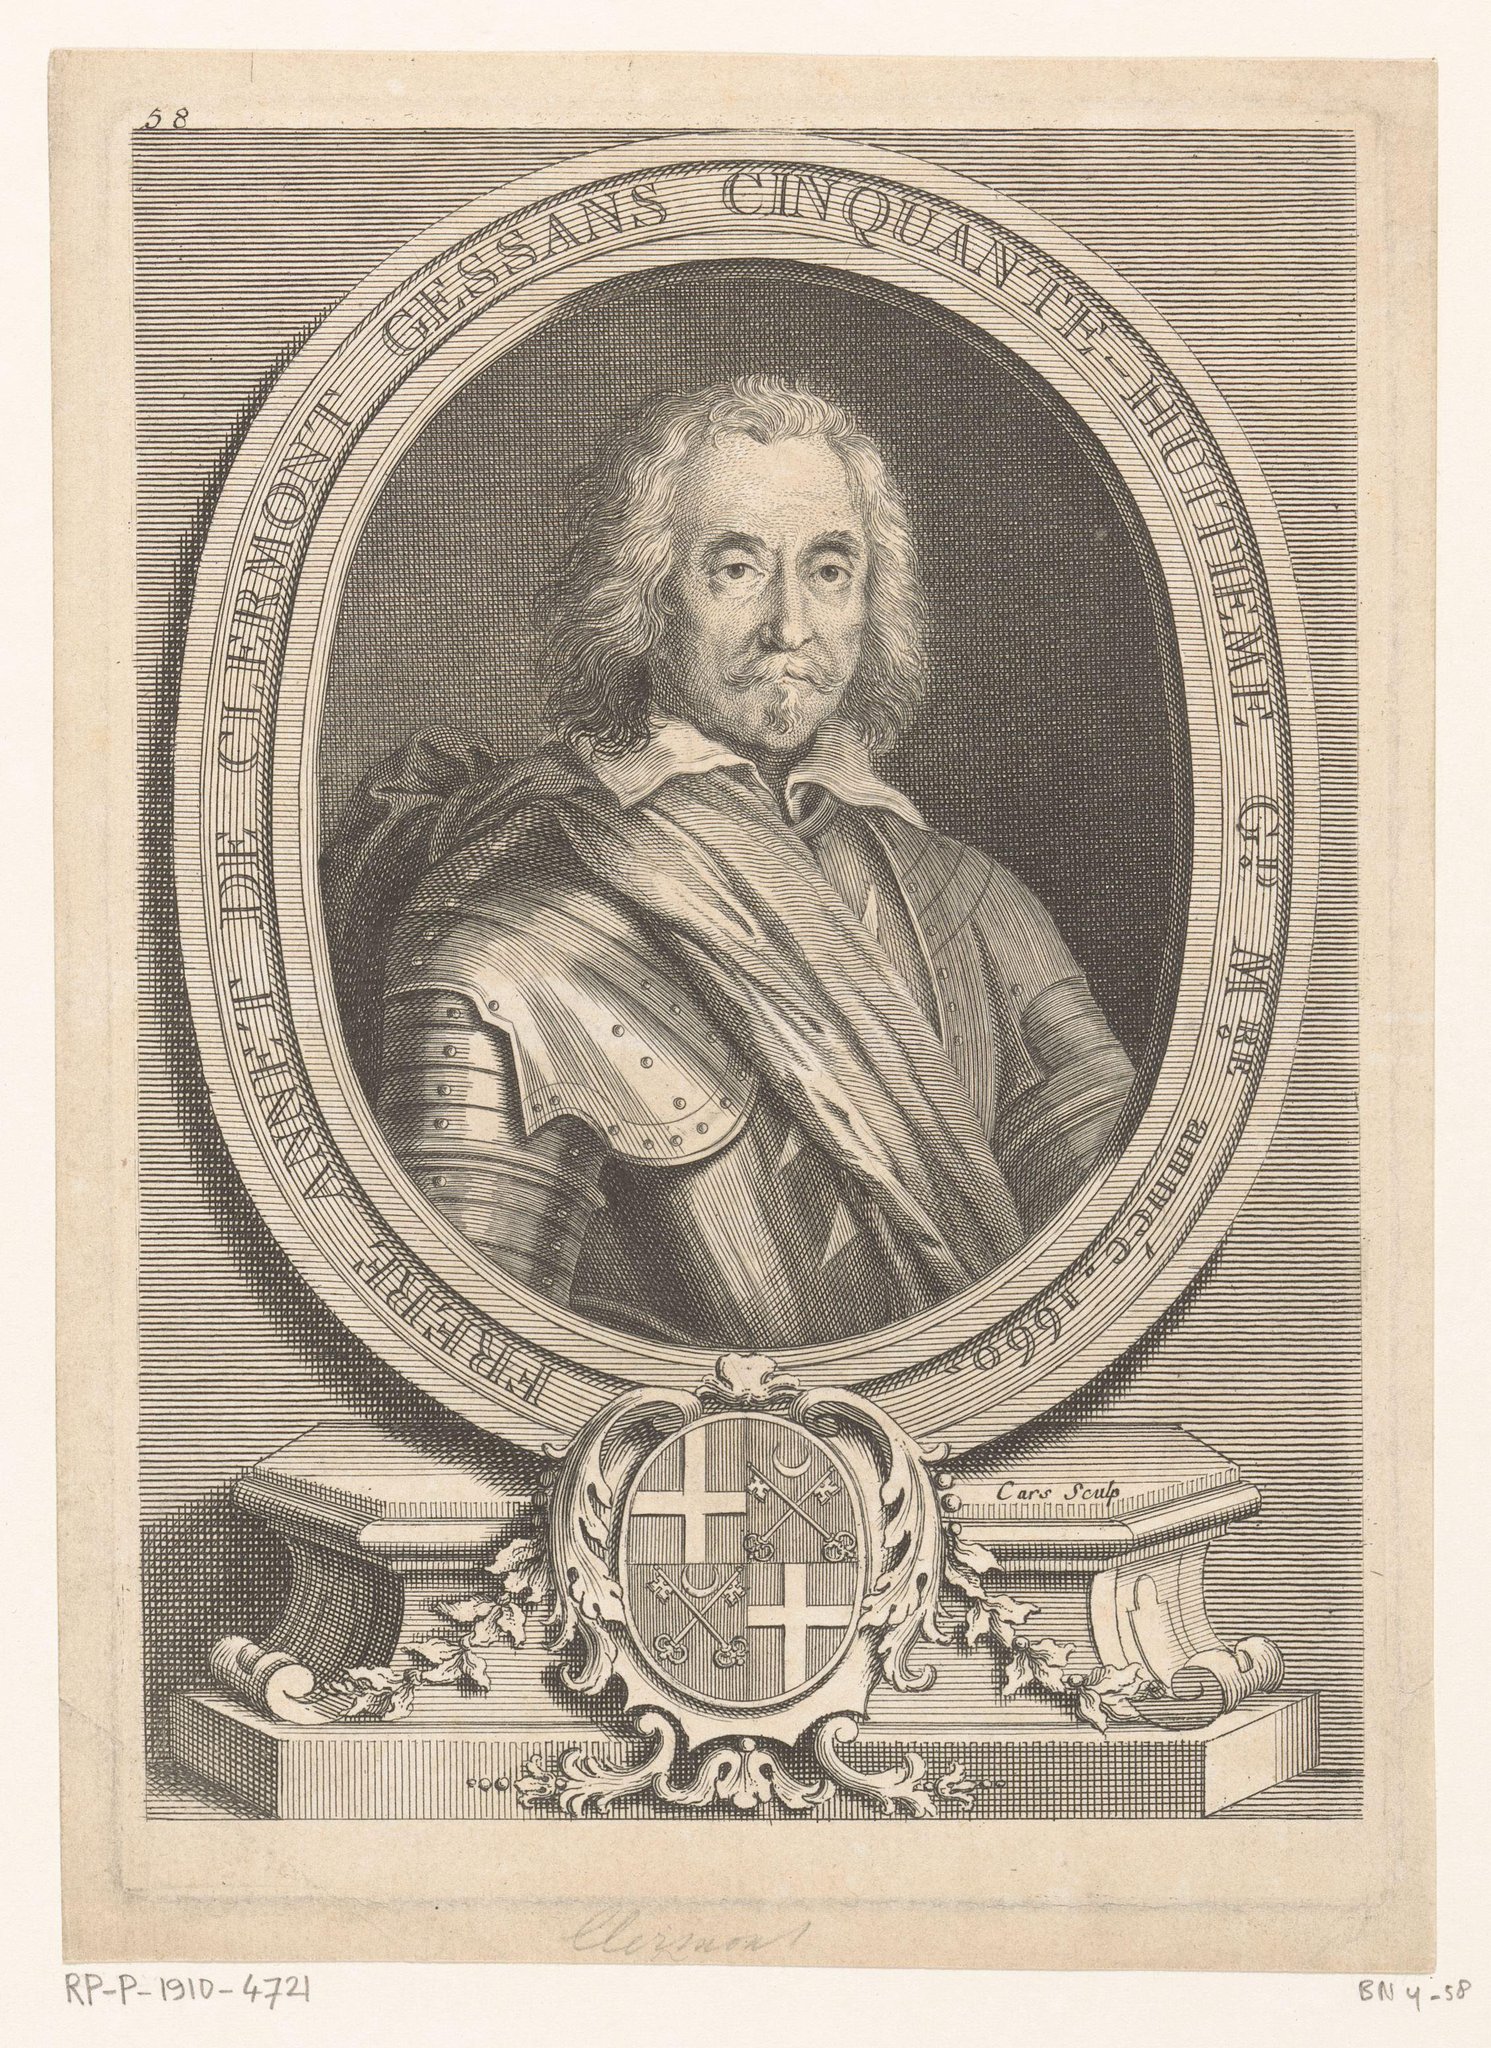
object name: book illustration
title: Pierre Annet de Clermont Gessans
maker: laurent cars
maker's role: print maker, publisher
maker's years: 1699-1771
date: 1726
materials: paper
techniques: engraving, etching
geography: france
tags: historical persons, military orders, e.g.: knights templars, knights of malta, teutonic knights ~ roman catholic church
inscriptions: collector's mark: Lugt 2228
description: Prent uit: Vertot, René Aubert de. Histoire des Chevaliers hospitaliers de St Jean de Jérusalem. Parijs: Rollin, Quillau, Desaint, 1726. Illustratie op p. 175 van deel 4. Cars vervaardigde portretten van 65 grootmeesters van de Maltezer Orde.